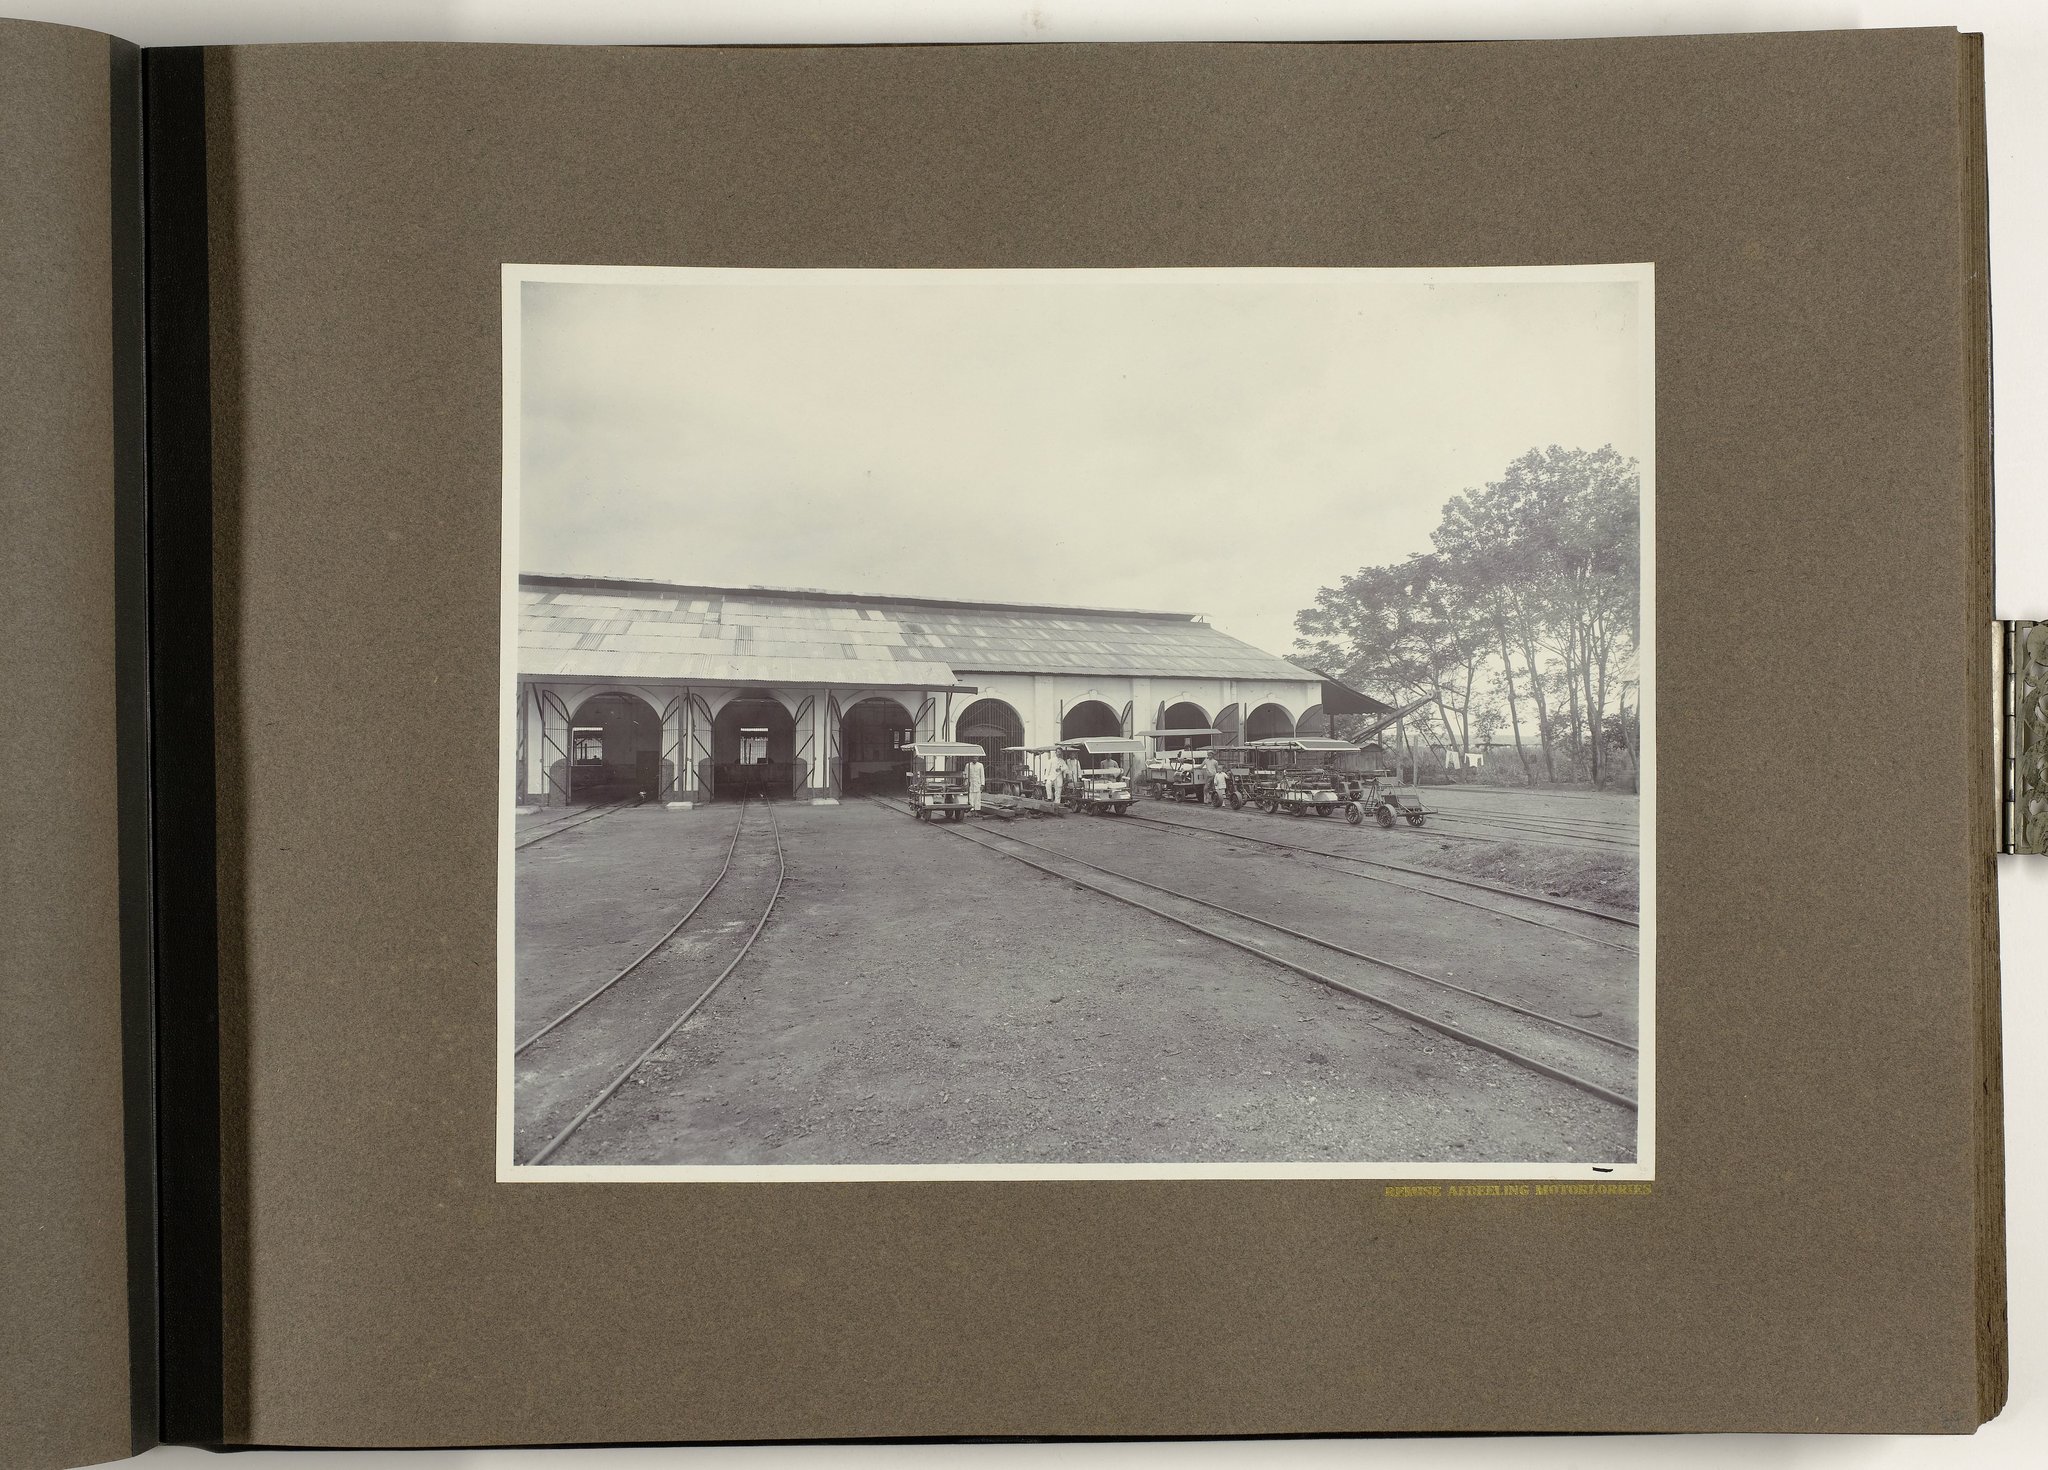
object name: photograph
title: Remise afdeeling motorlorries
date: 1917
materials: photographic support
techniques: gelatin silver print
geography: jatiroto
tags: truck, van, colonial system, (non-fruit) products of plants or trees: sugarcane, interior of industrial structures (regardless of the materials processed or the products made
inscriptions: inscription: ‘REMISE AFDEELING MOTORLORRIES’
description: De remise van de Afdeling Motorlorries met een aantal lorries, naast de draisines poseren werknemers. Onderdeel van het fotoalbum aangeboden aan F.J. Wirix door het personeel van de Suikeronderneming Djatiroto in 1917.